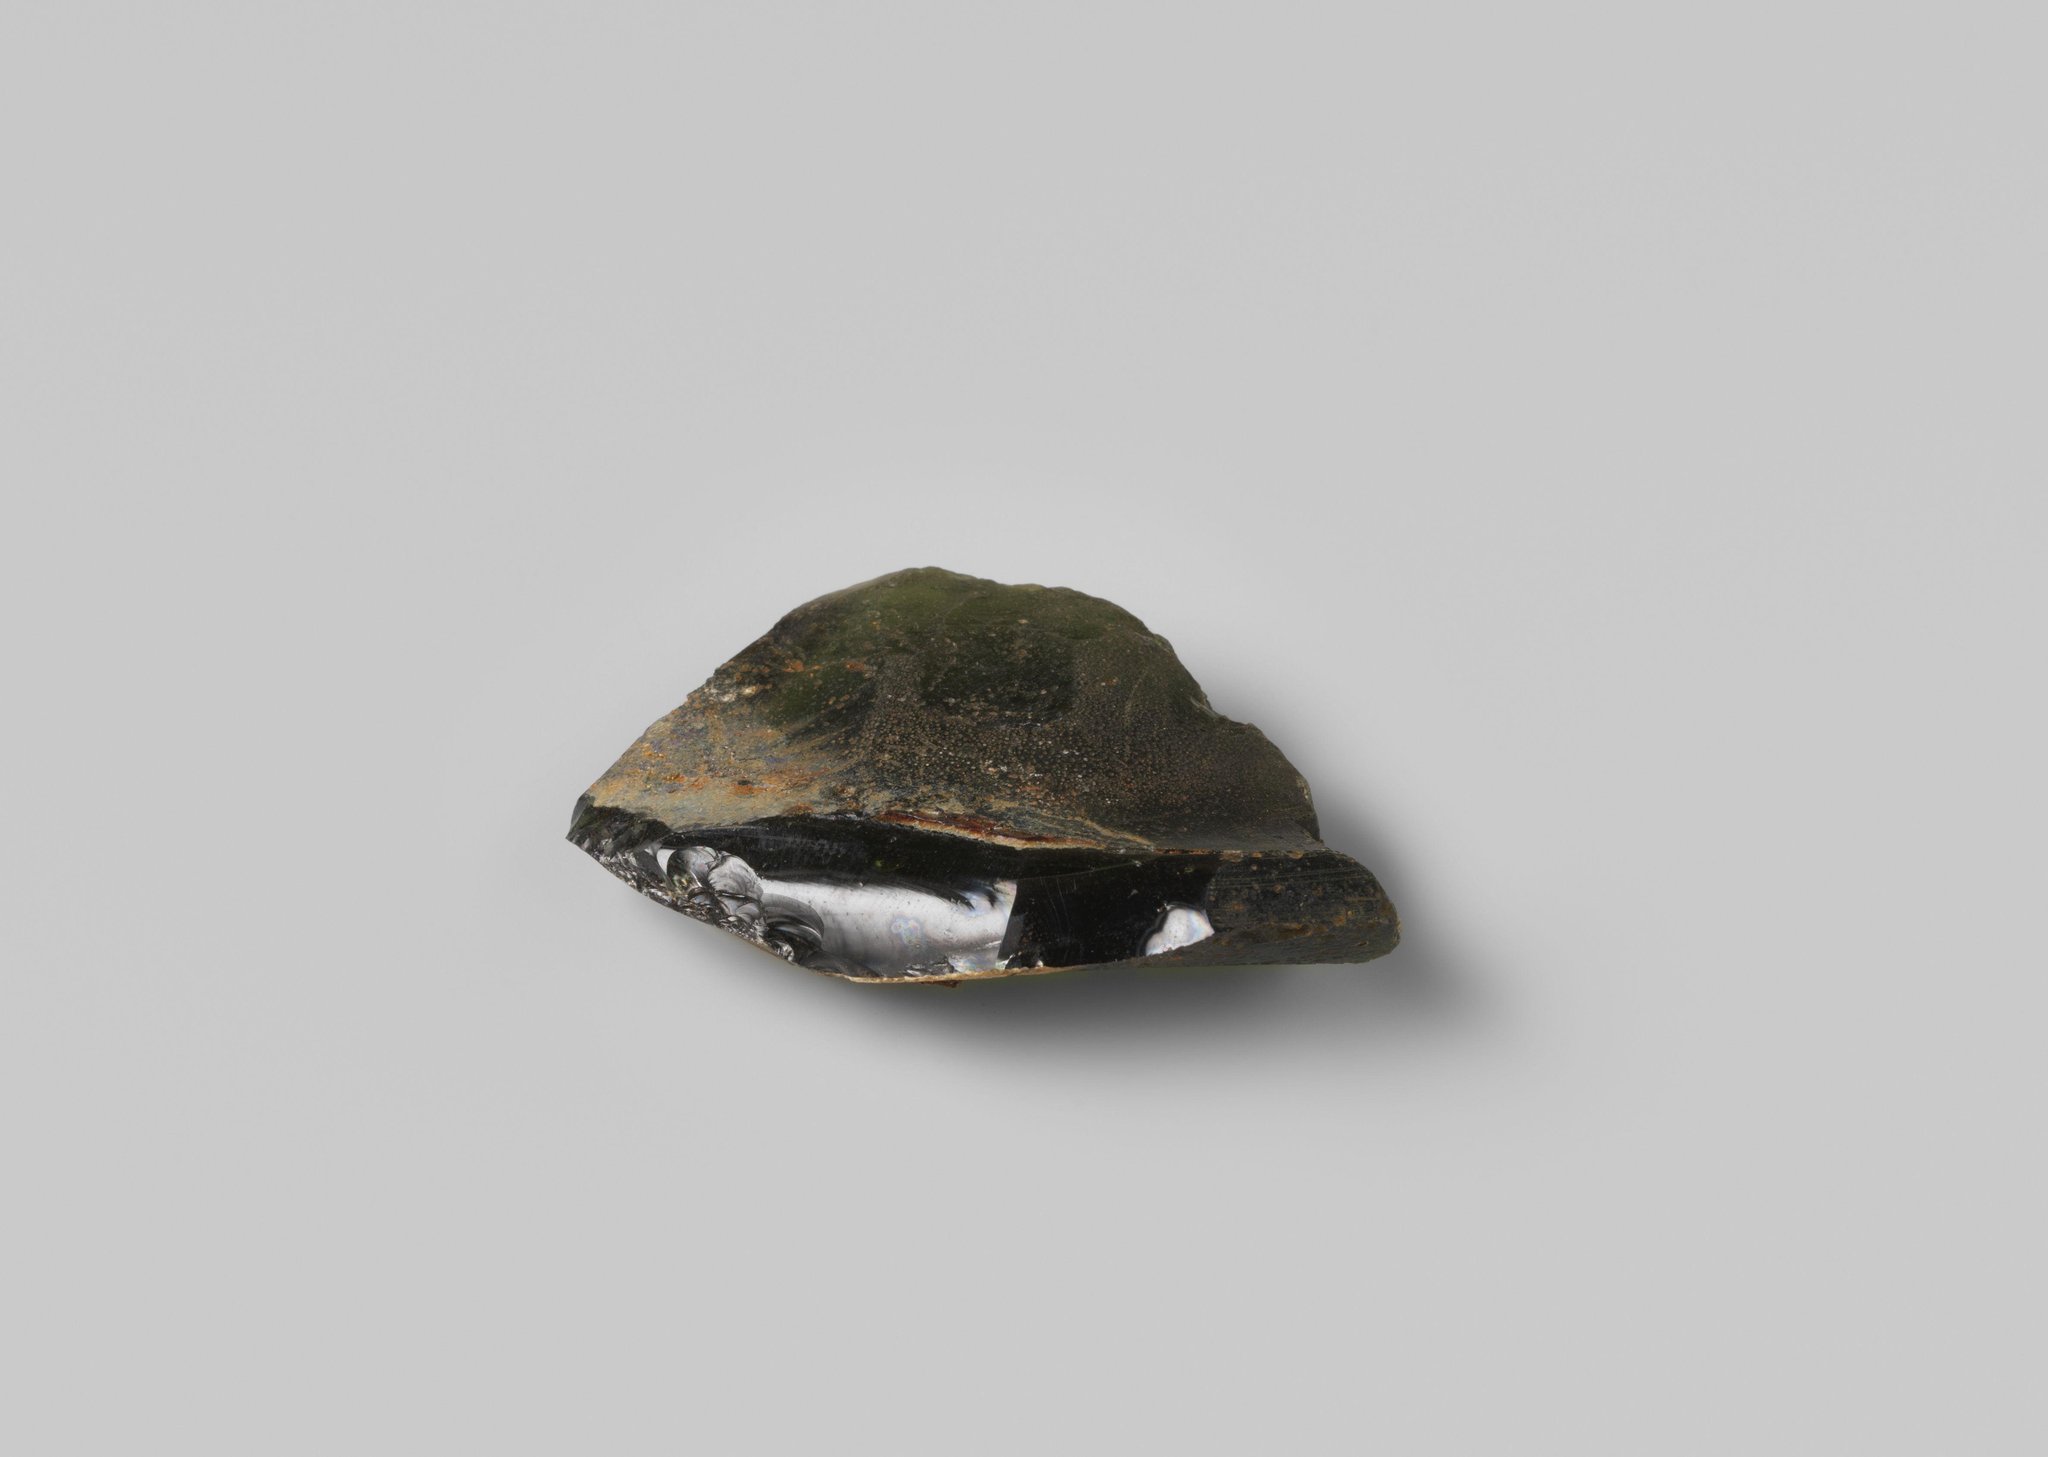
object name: wine bottle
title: Scherf van een wijnfles uit het wrak van de Oostindiëvaarder Hollandia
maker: Anonymous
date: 1700-1743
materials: glass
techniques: green glass